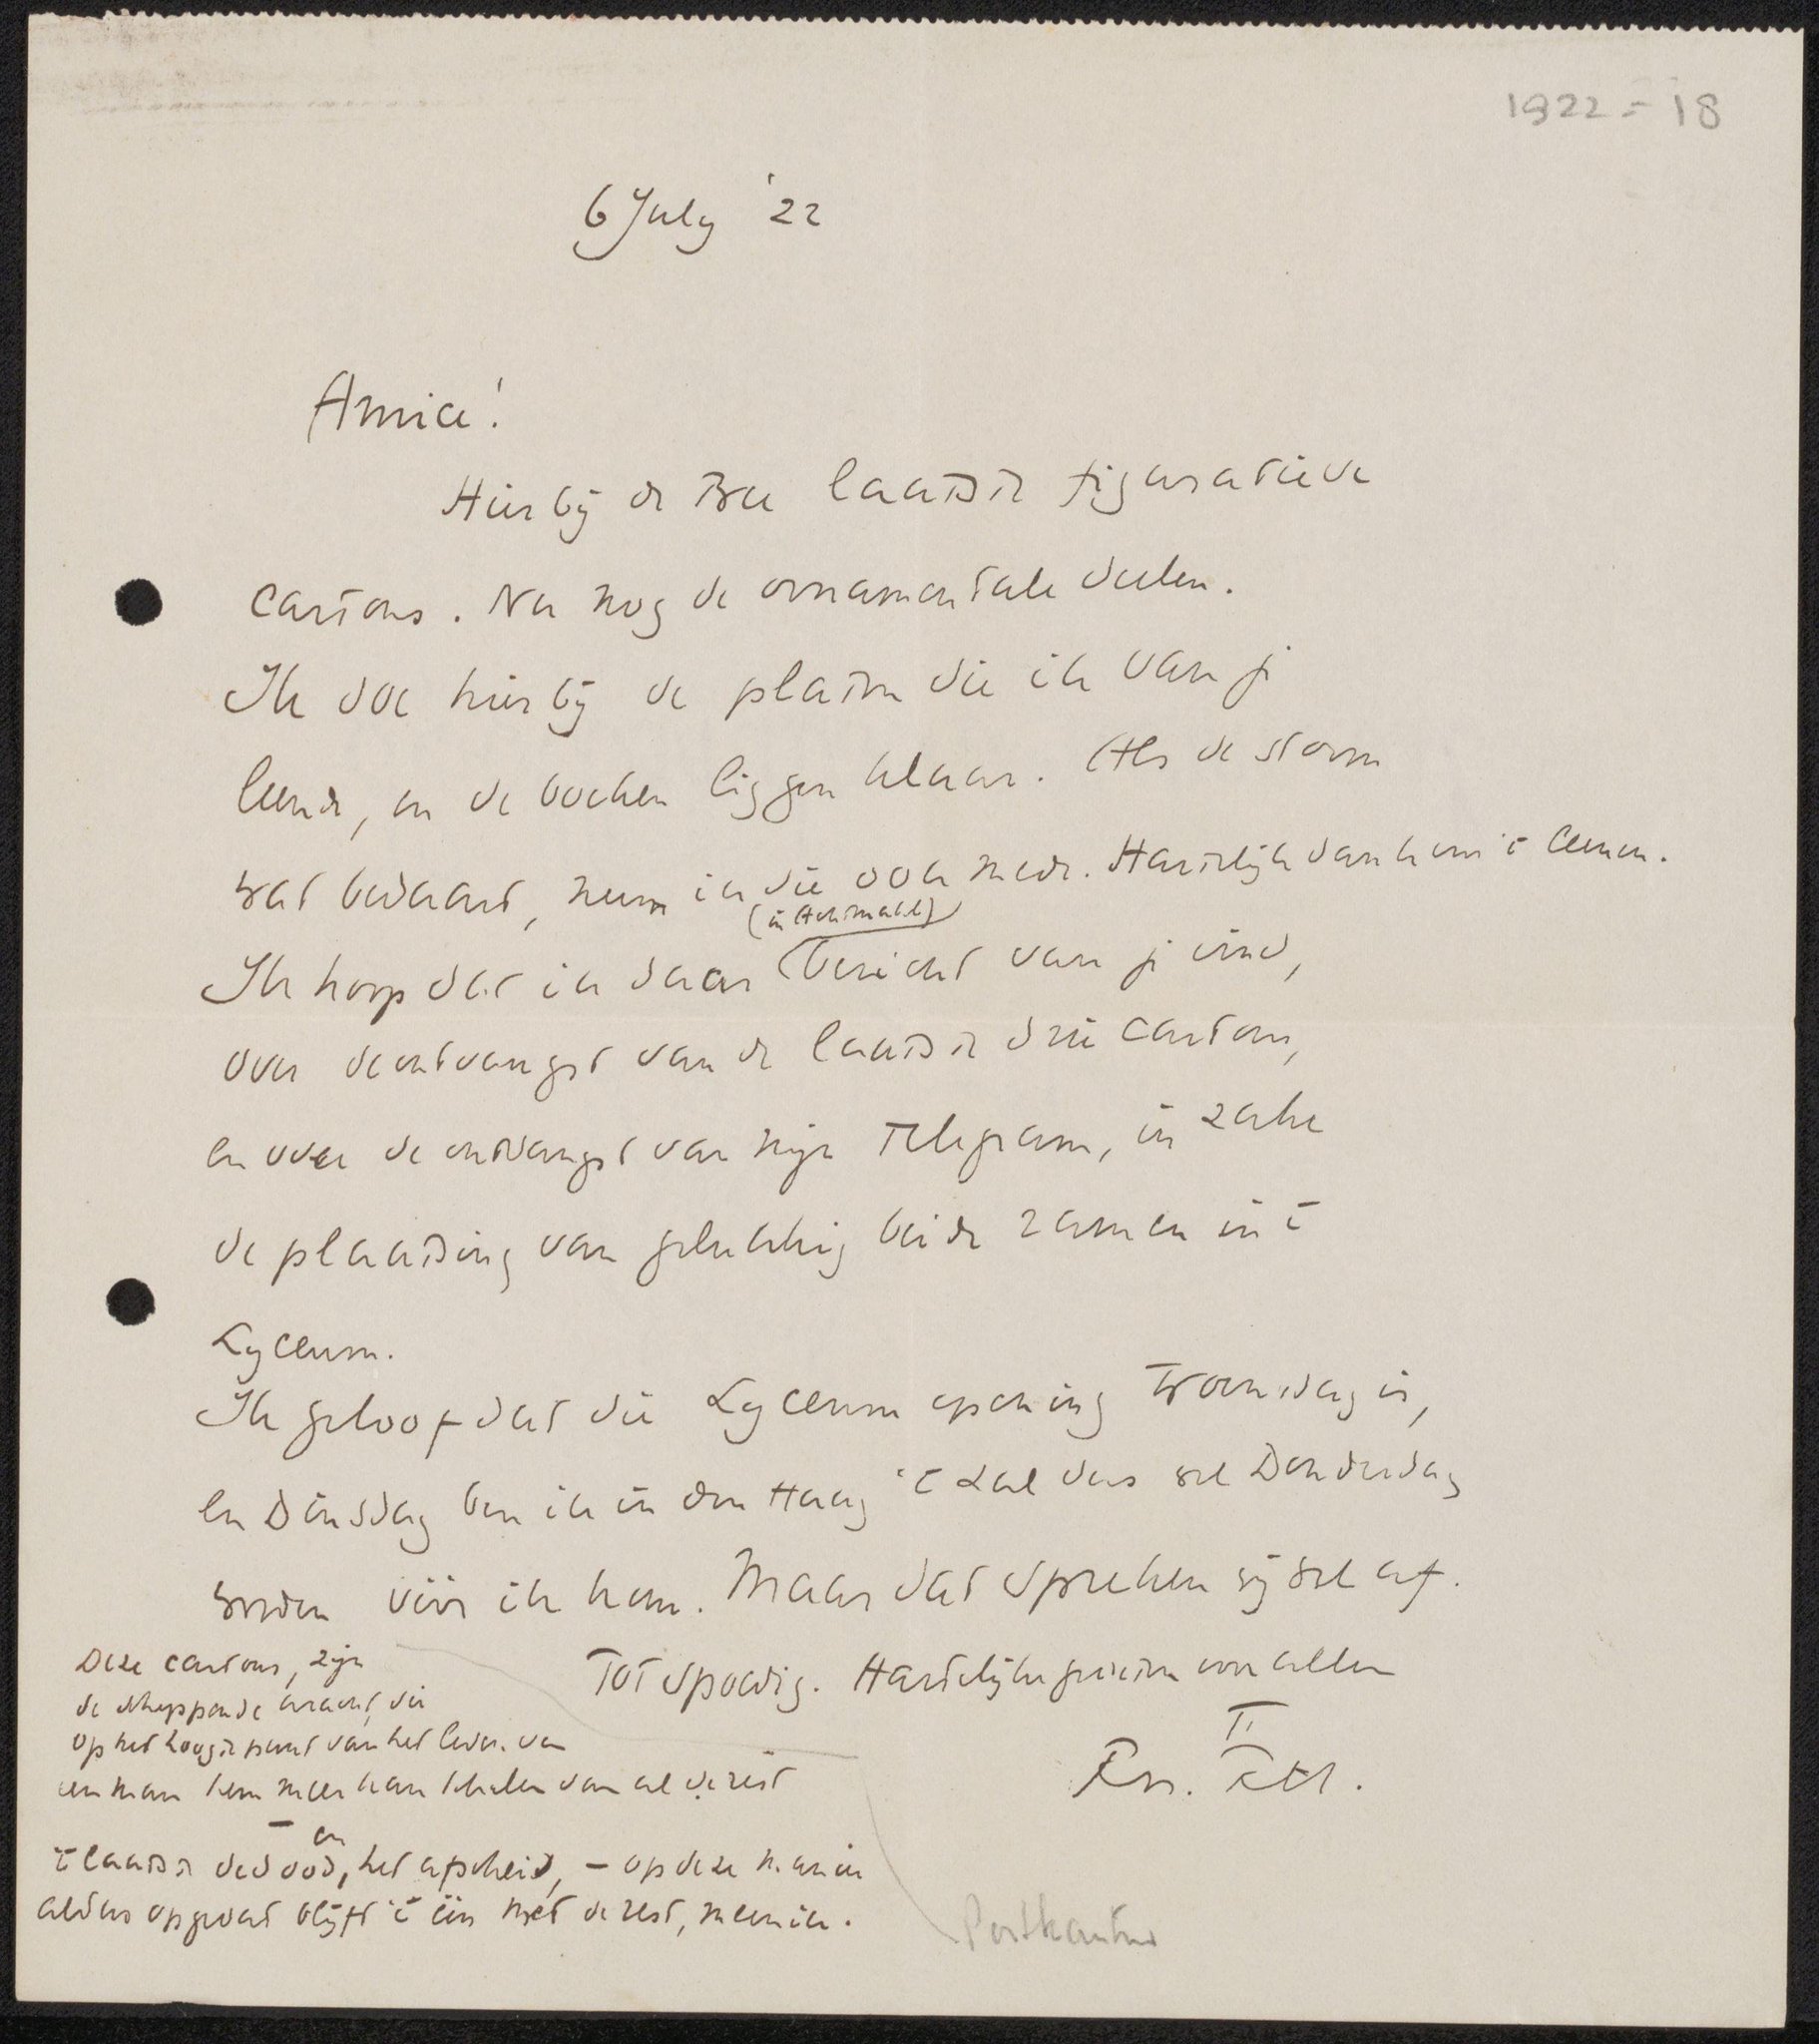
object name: letter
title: Brief aan Willem Bogtman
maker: richard nicolaüs roland holst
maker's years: 1868-1938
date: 1922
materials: ink, paper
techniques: pen, writing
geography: bloemendaal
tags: haarlem, willem bogtman, drawing, applied arts, arts and crafts; industrial design, the hague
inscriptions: watermark